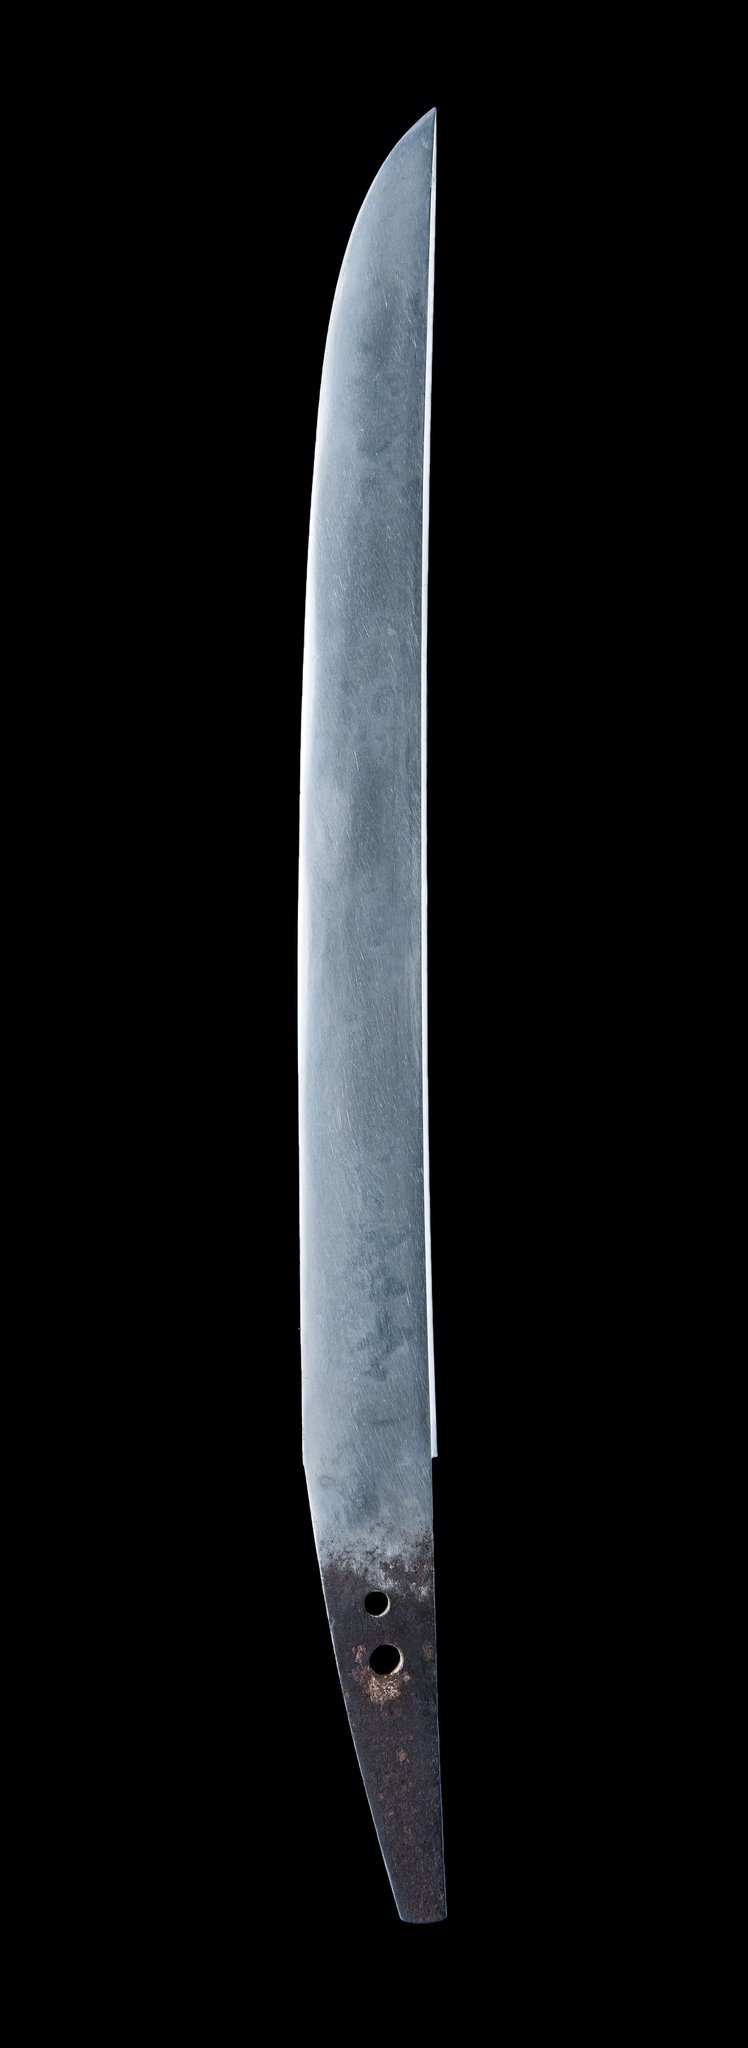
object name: blade and mounting for a dagger tantō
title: Blade and Mounting for a Dagger (Tantō)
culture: japanese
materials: gold alloy, gold, lacquer, steel, thread, wood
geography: japan